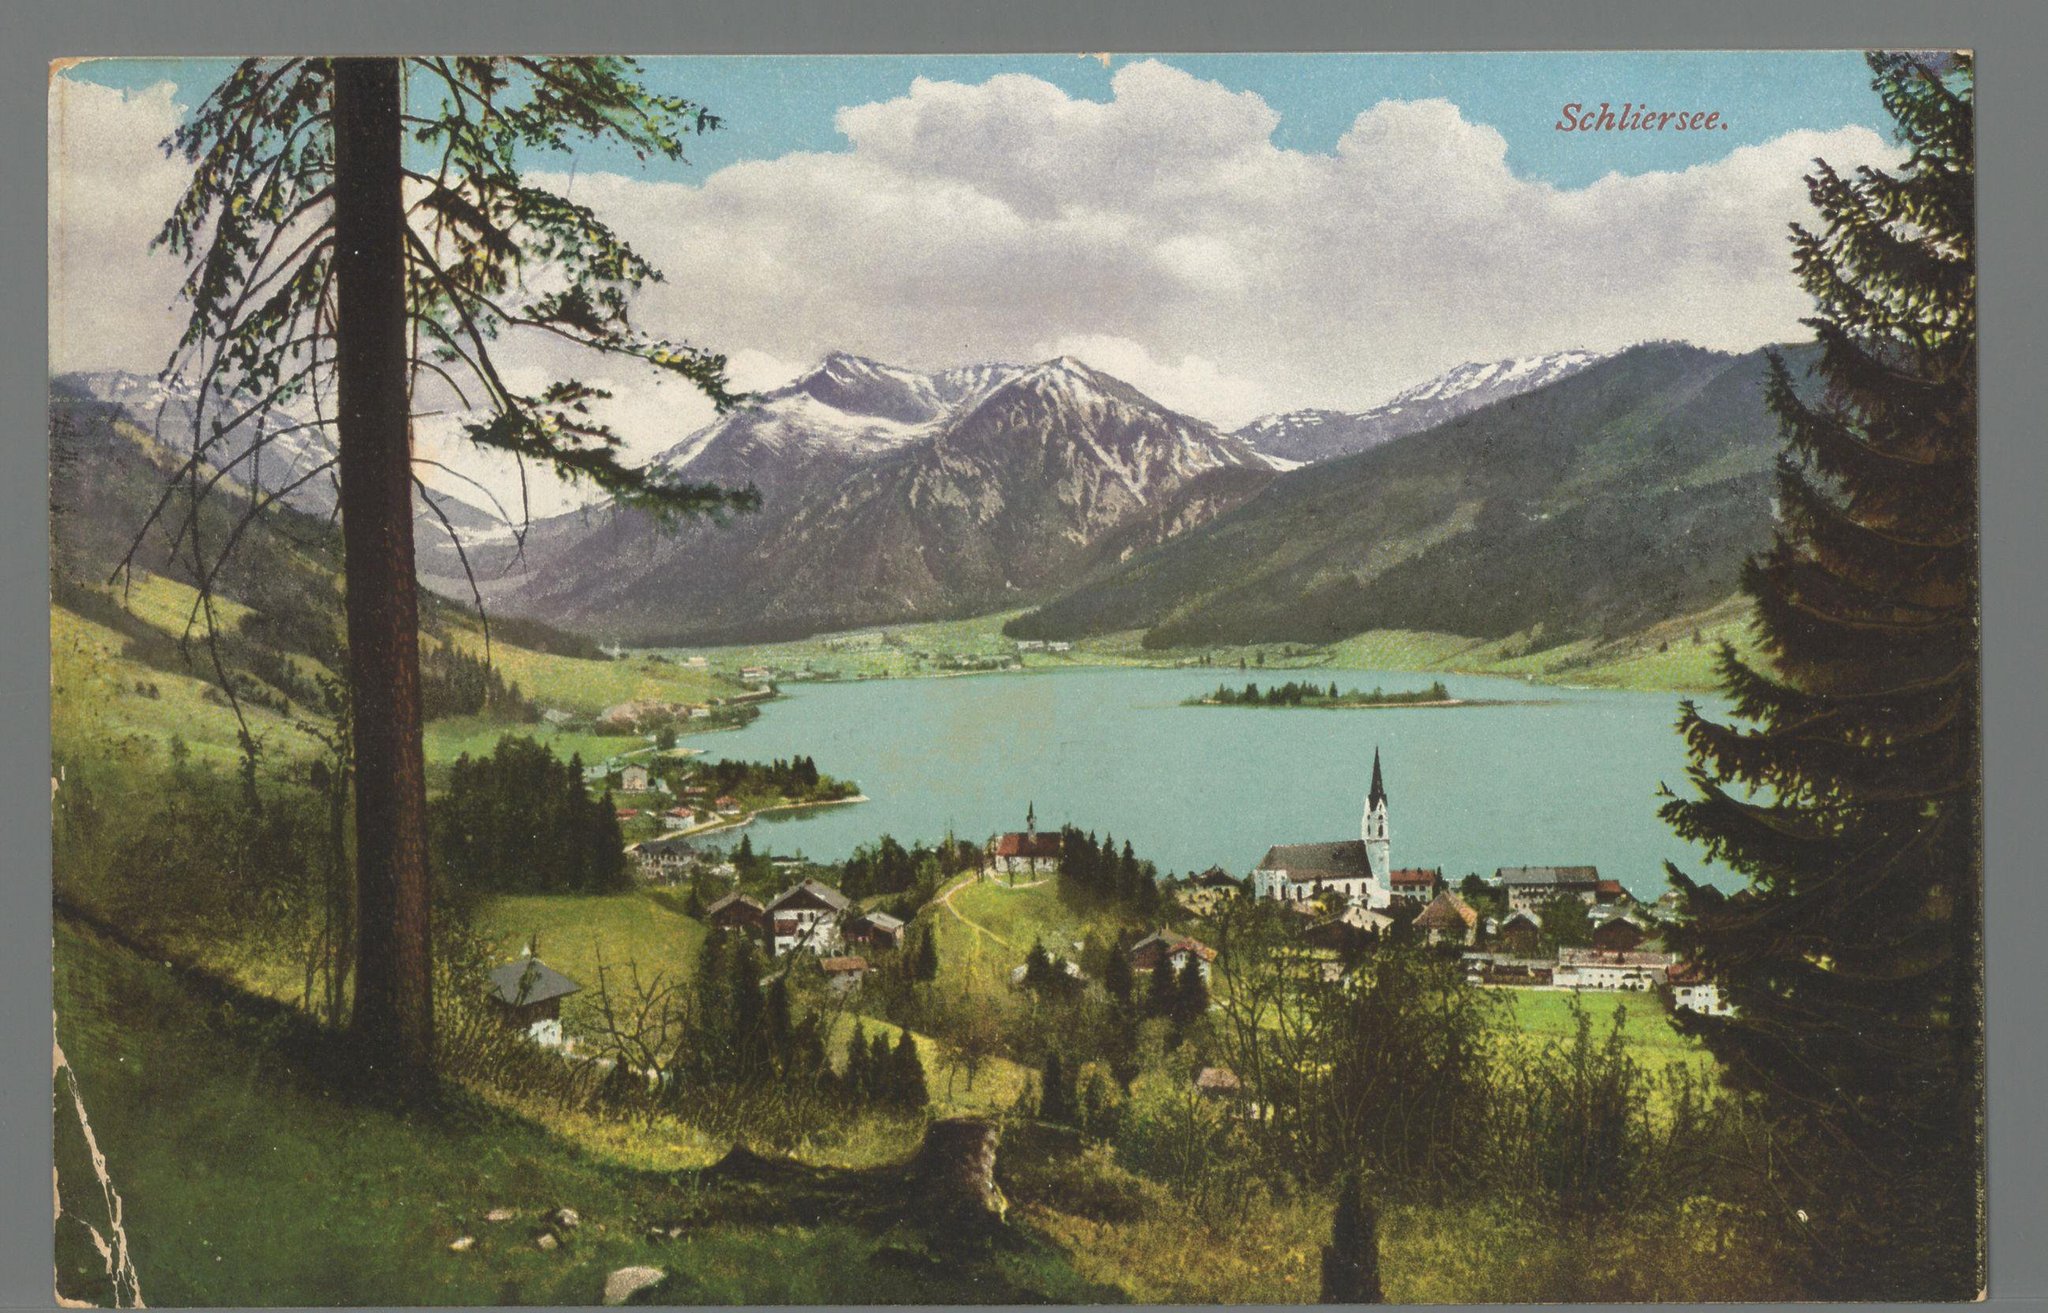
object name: ansichtkaart, prentbriefkaart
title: Schliersee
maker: Anonymous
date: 1905-1930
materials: cardboard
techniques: lithograph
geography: munich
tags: lake, mountains